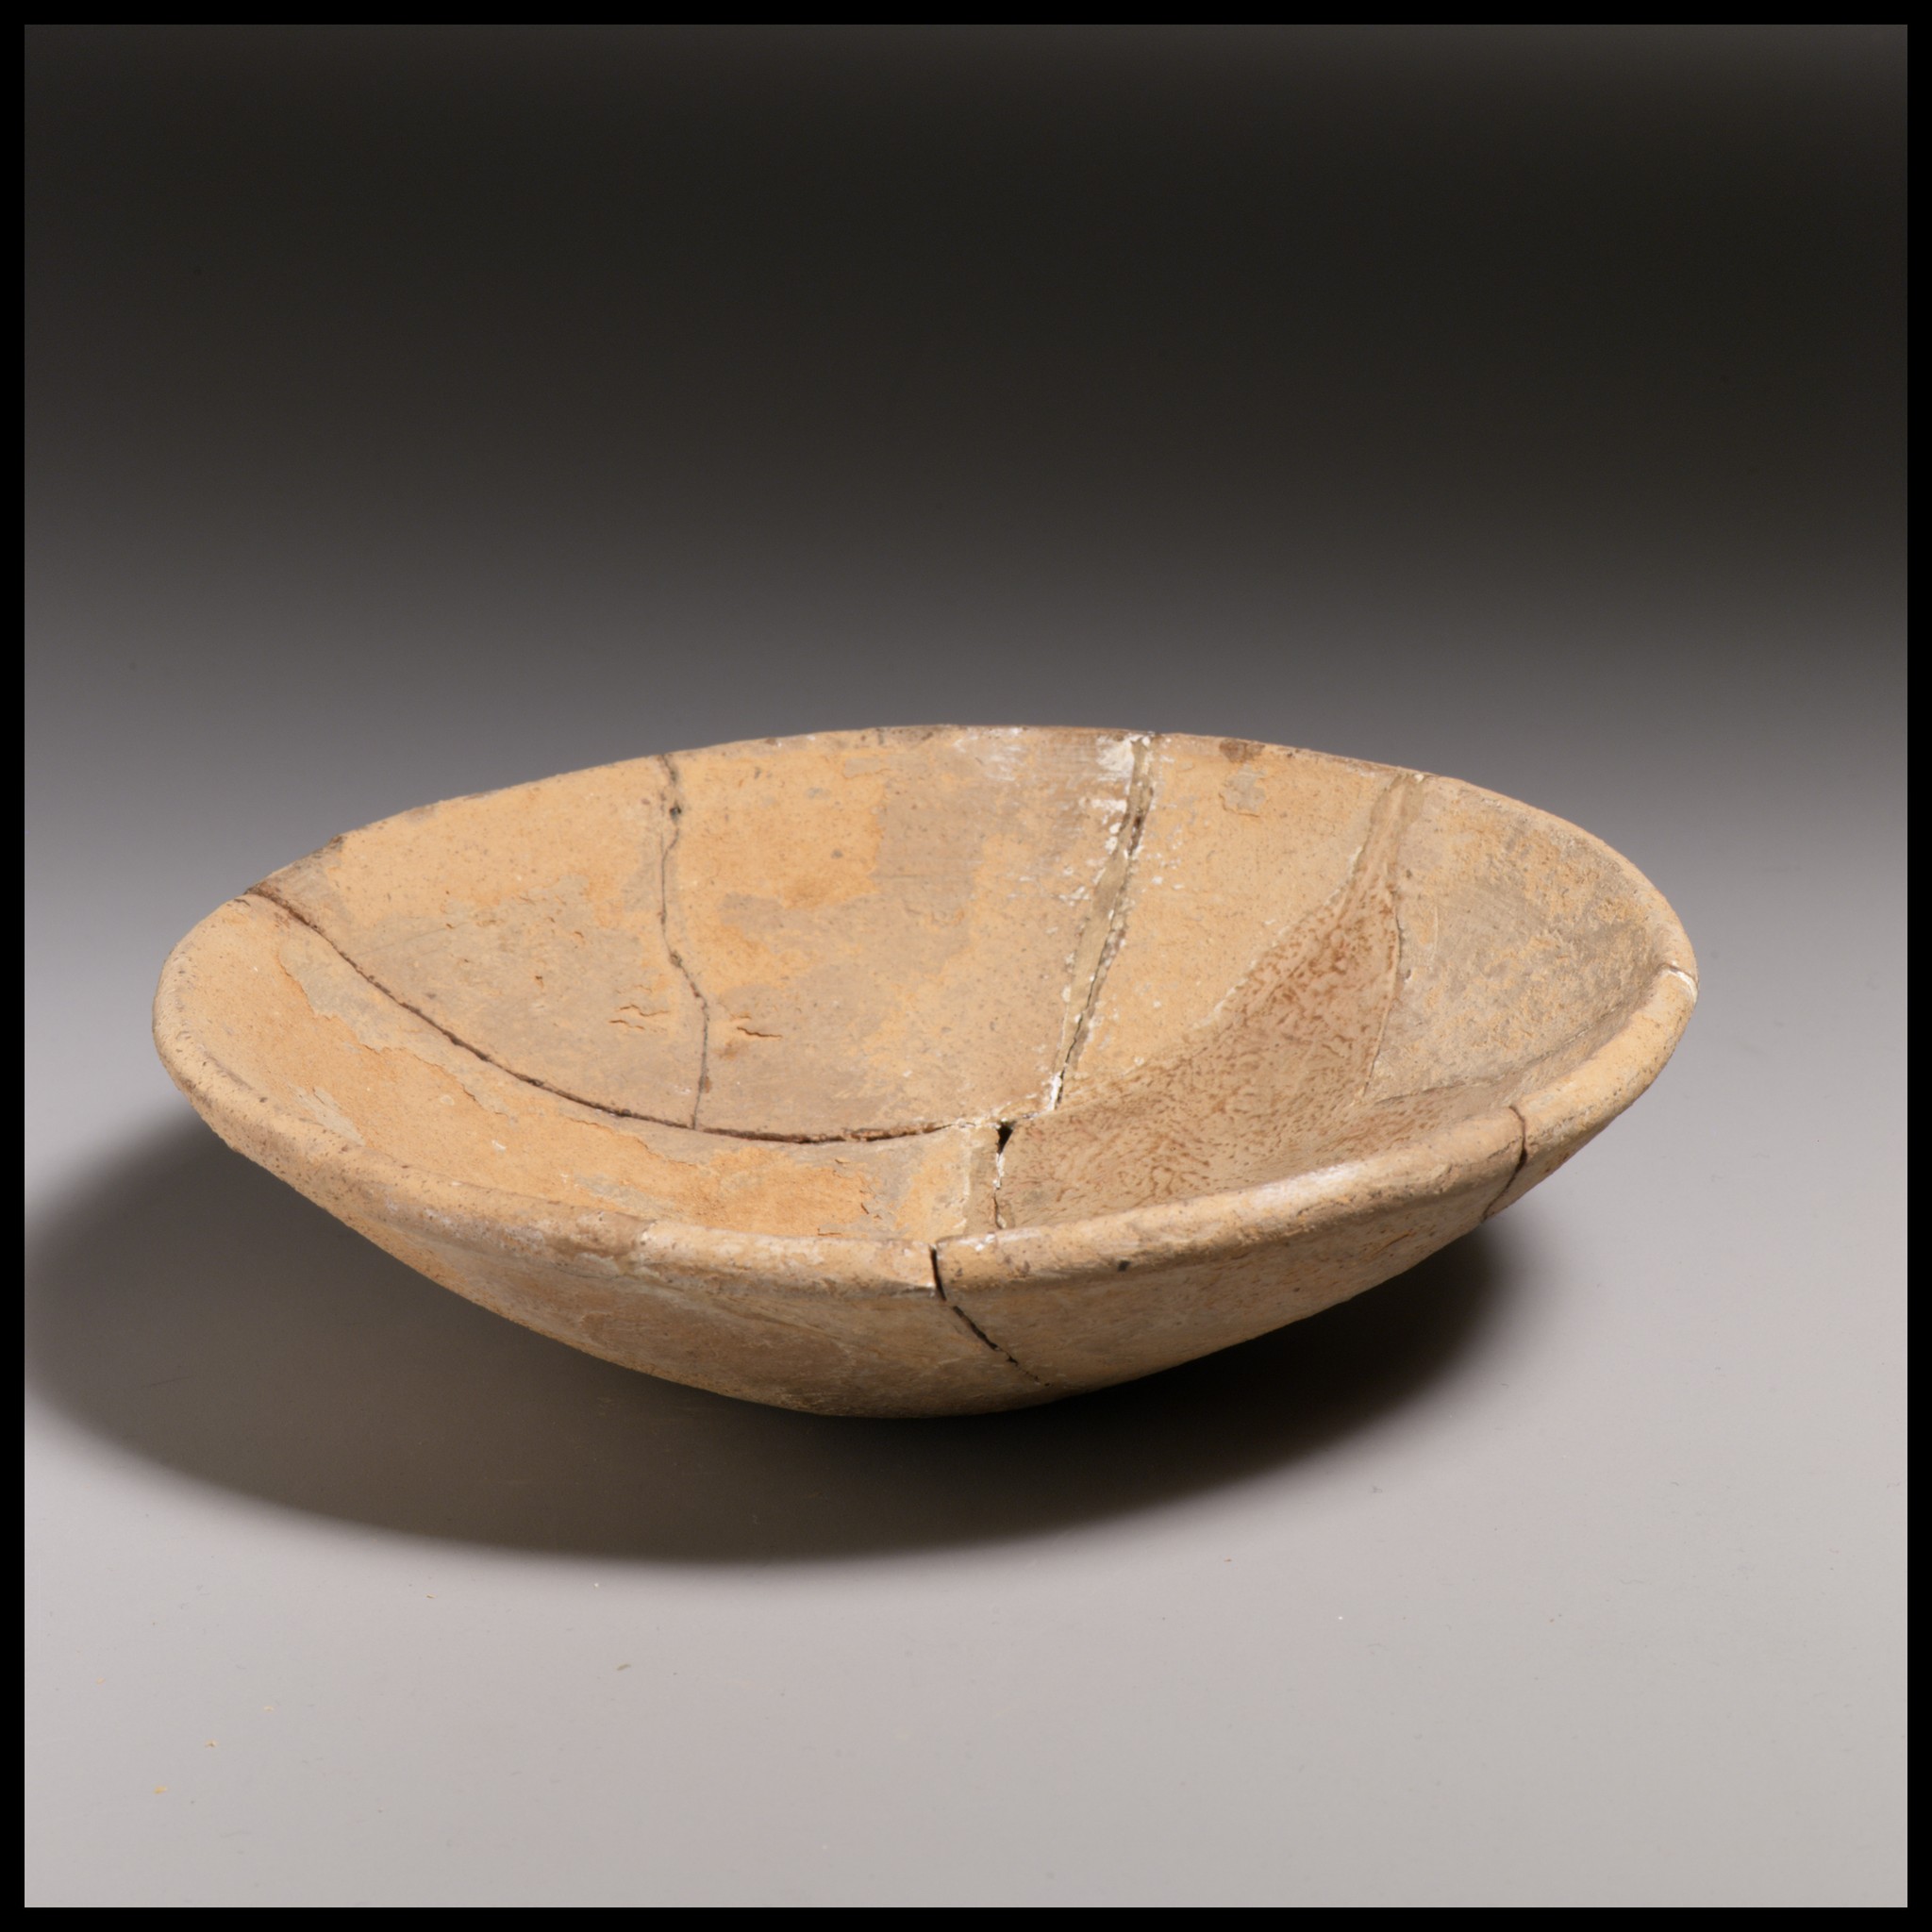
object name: bowl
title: Terracotta bowl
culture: helladic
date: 2650-2150 BCE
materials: terracotta